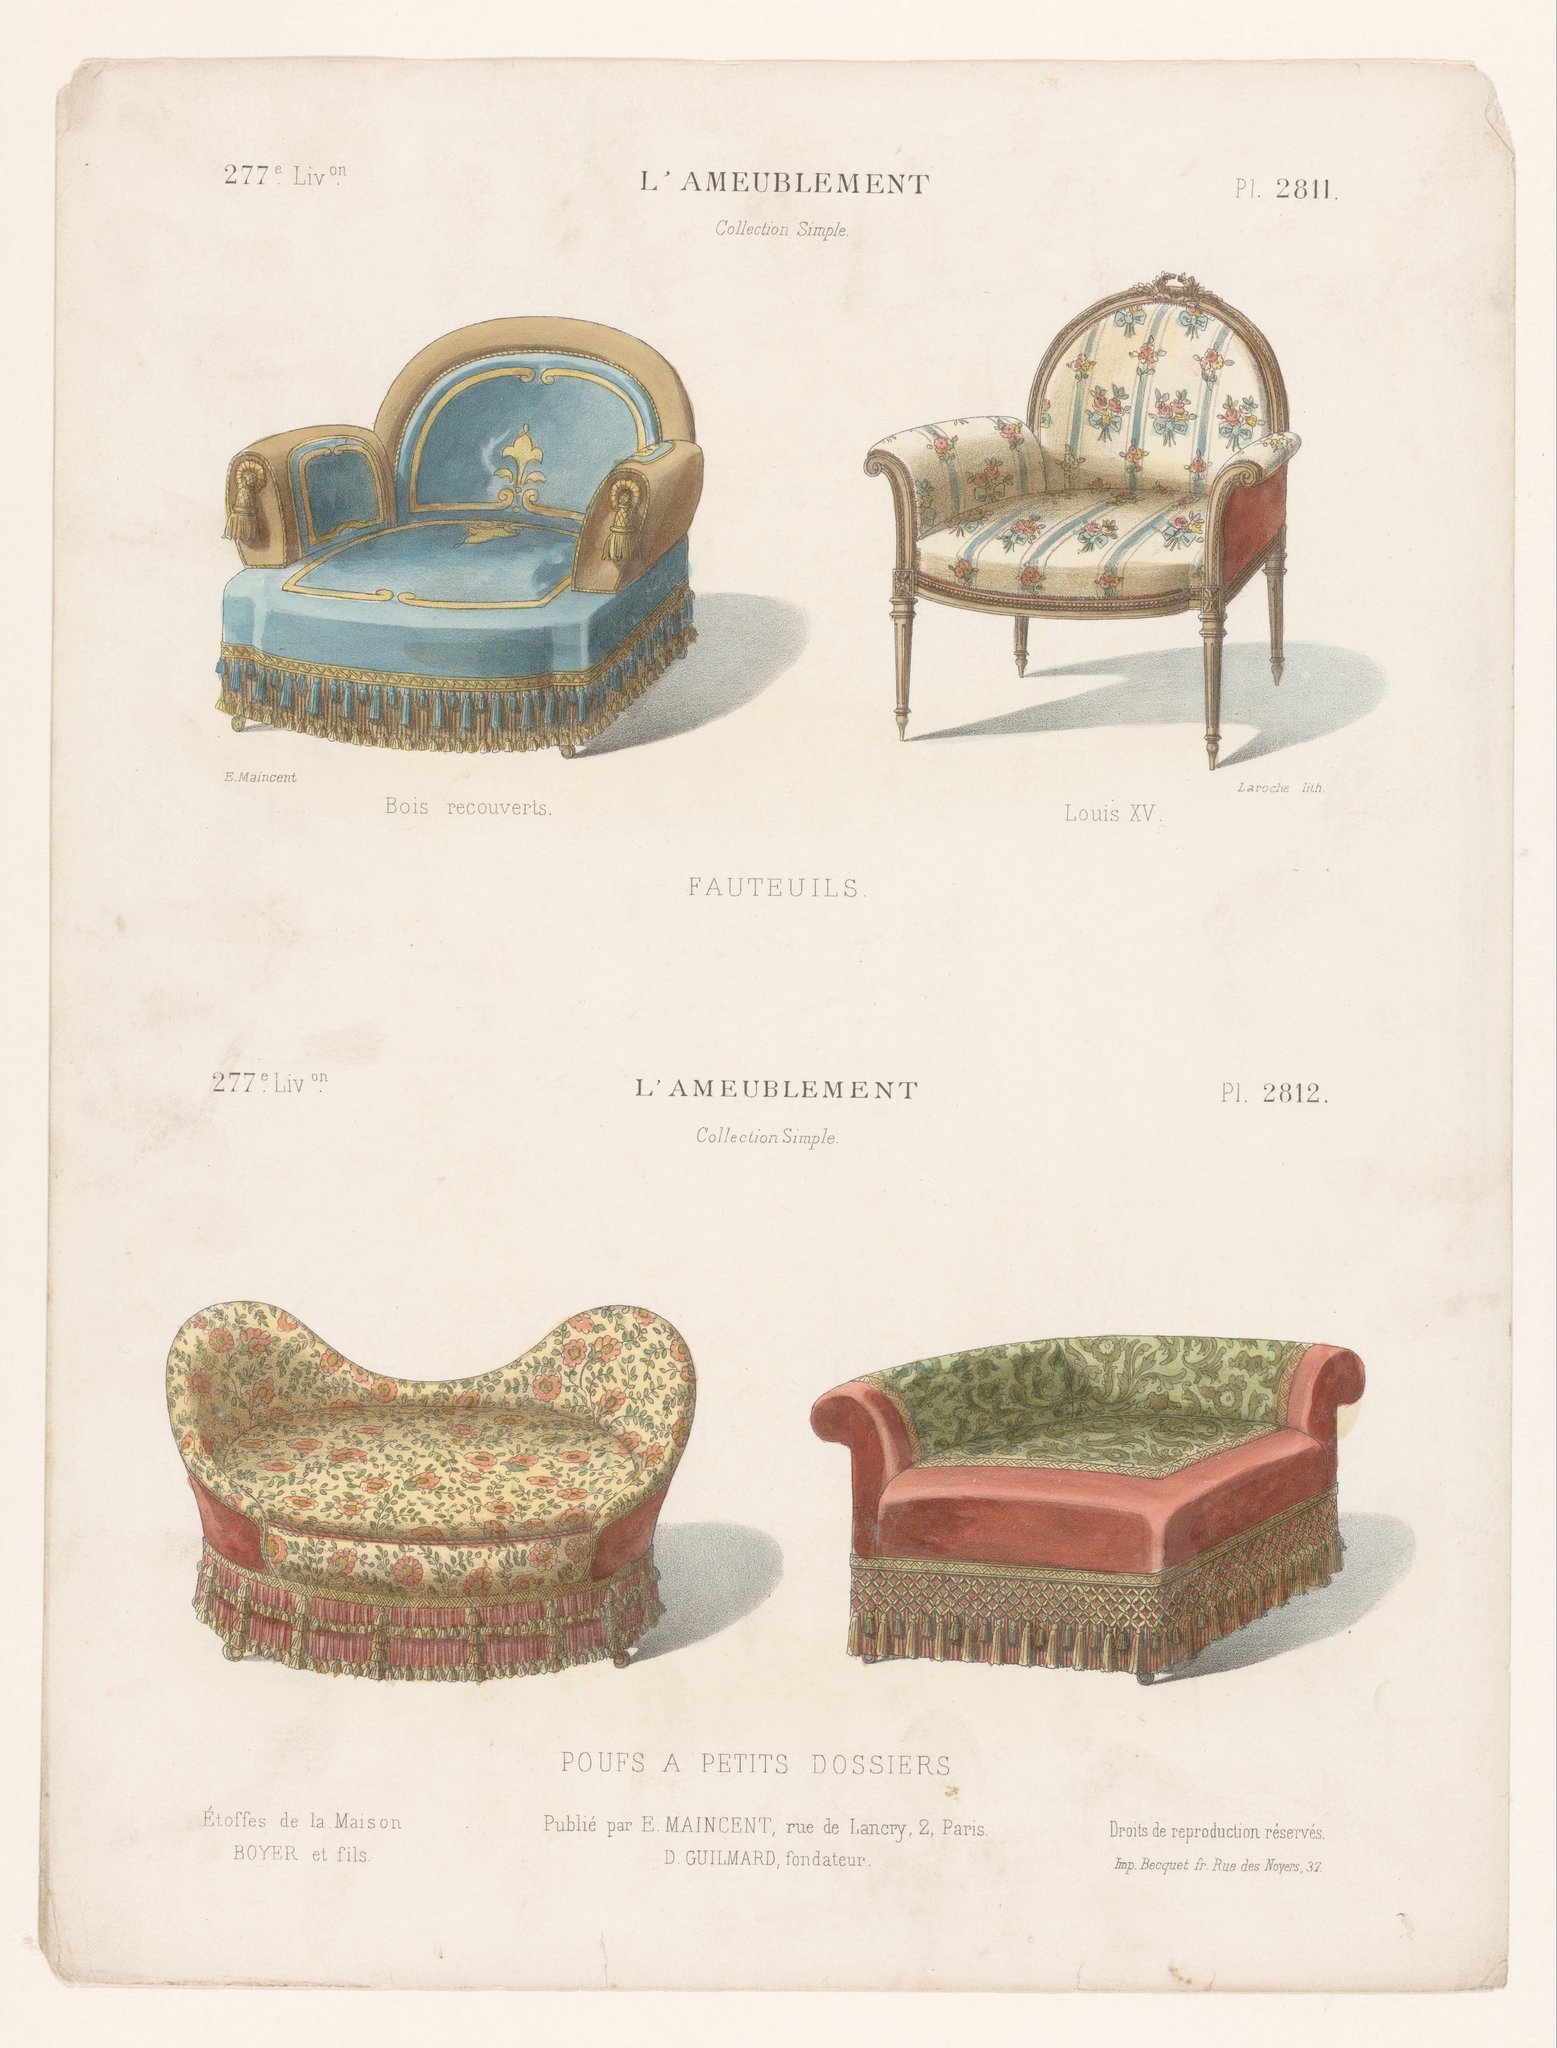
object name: print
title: L'ameublement / Collection simple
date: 1885-1895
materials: paper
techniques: hand coloring, lithograph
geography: paris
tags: seating furniture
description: Twee fauteuils en twee poefen. Prent uit 277e Livraison.